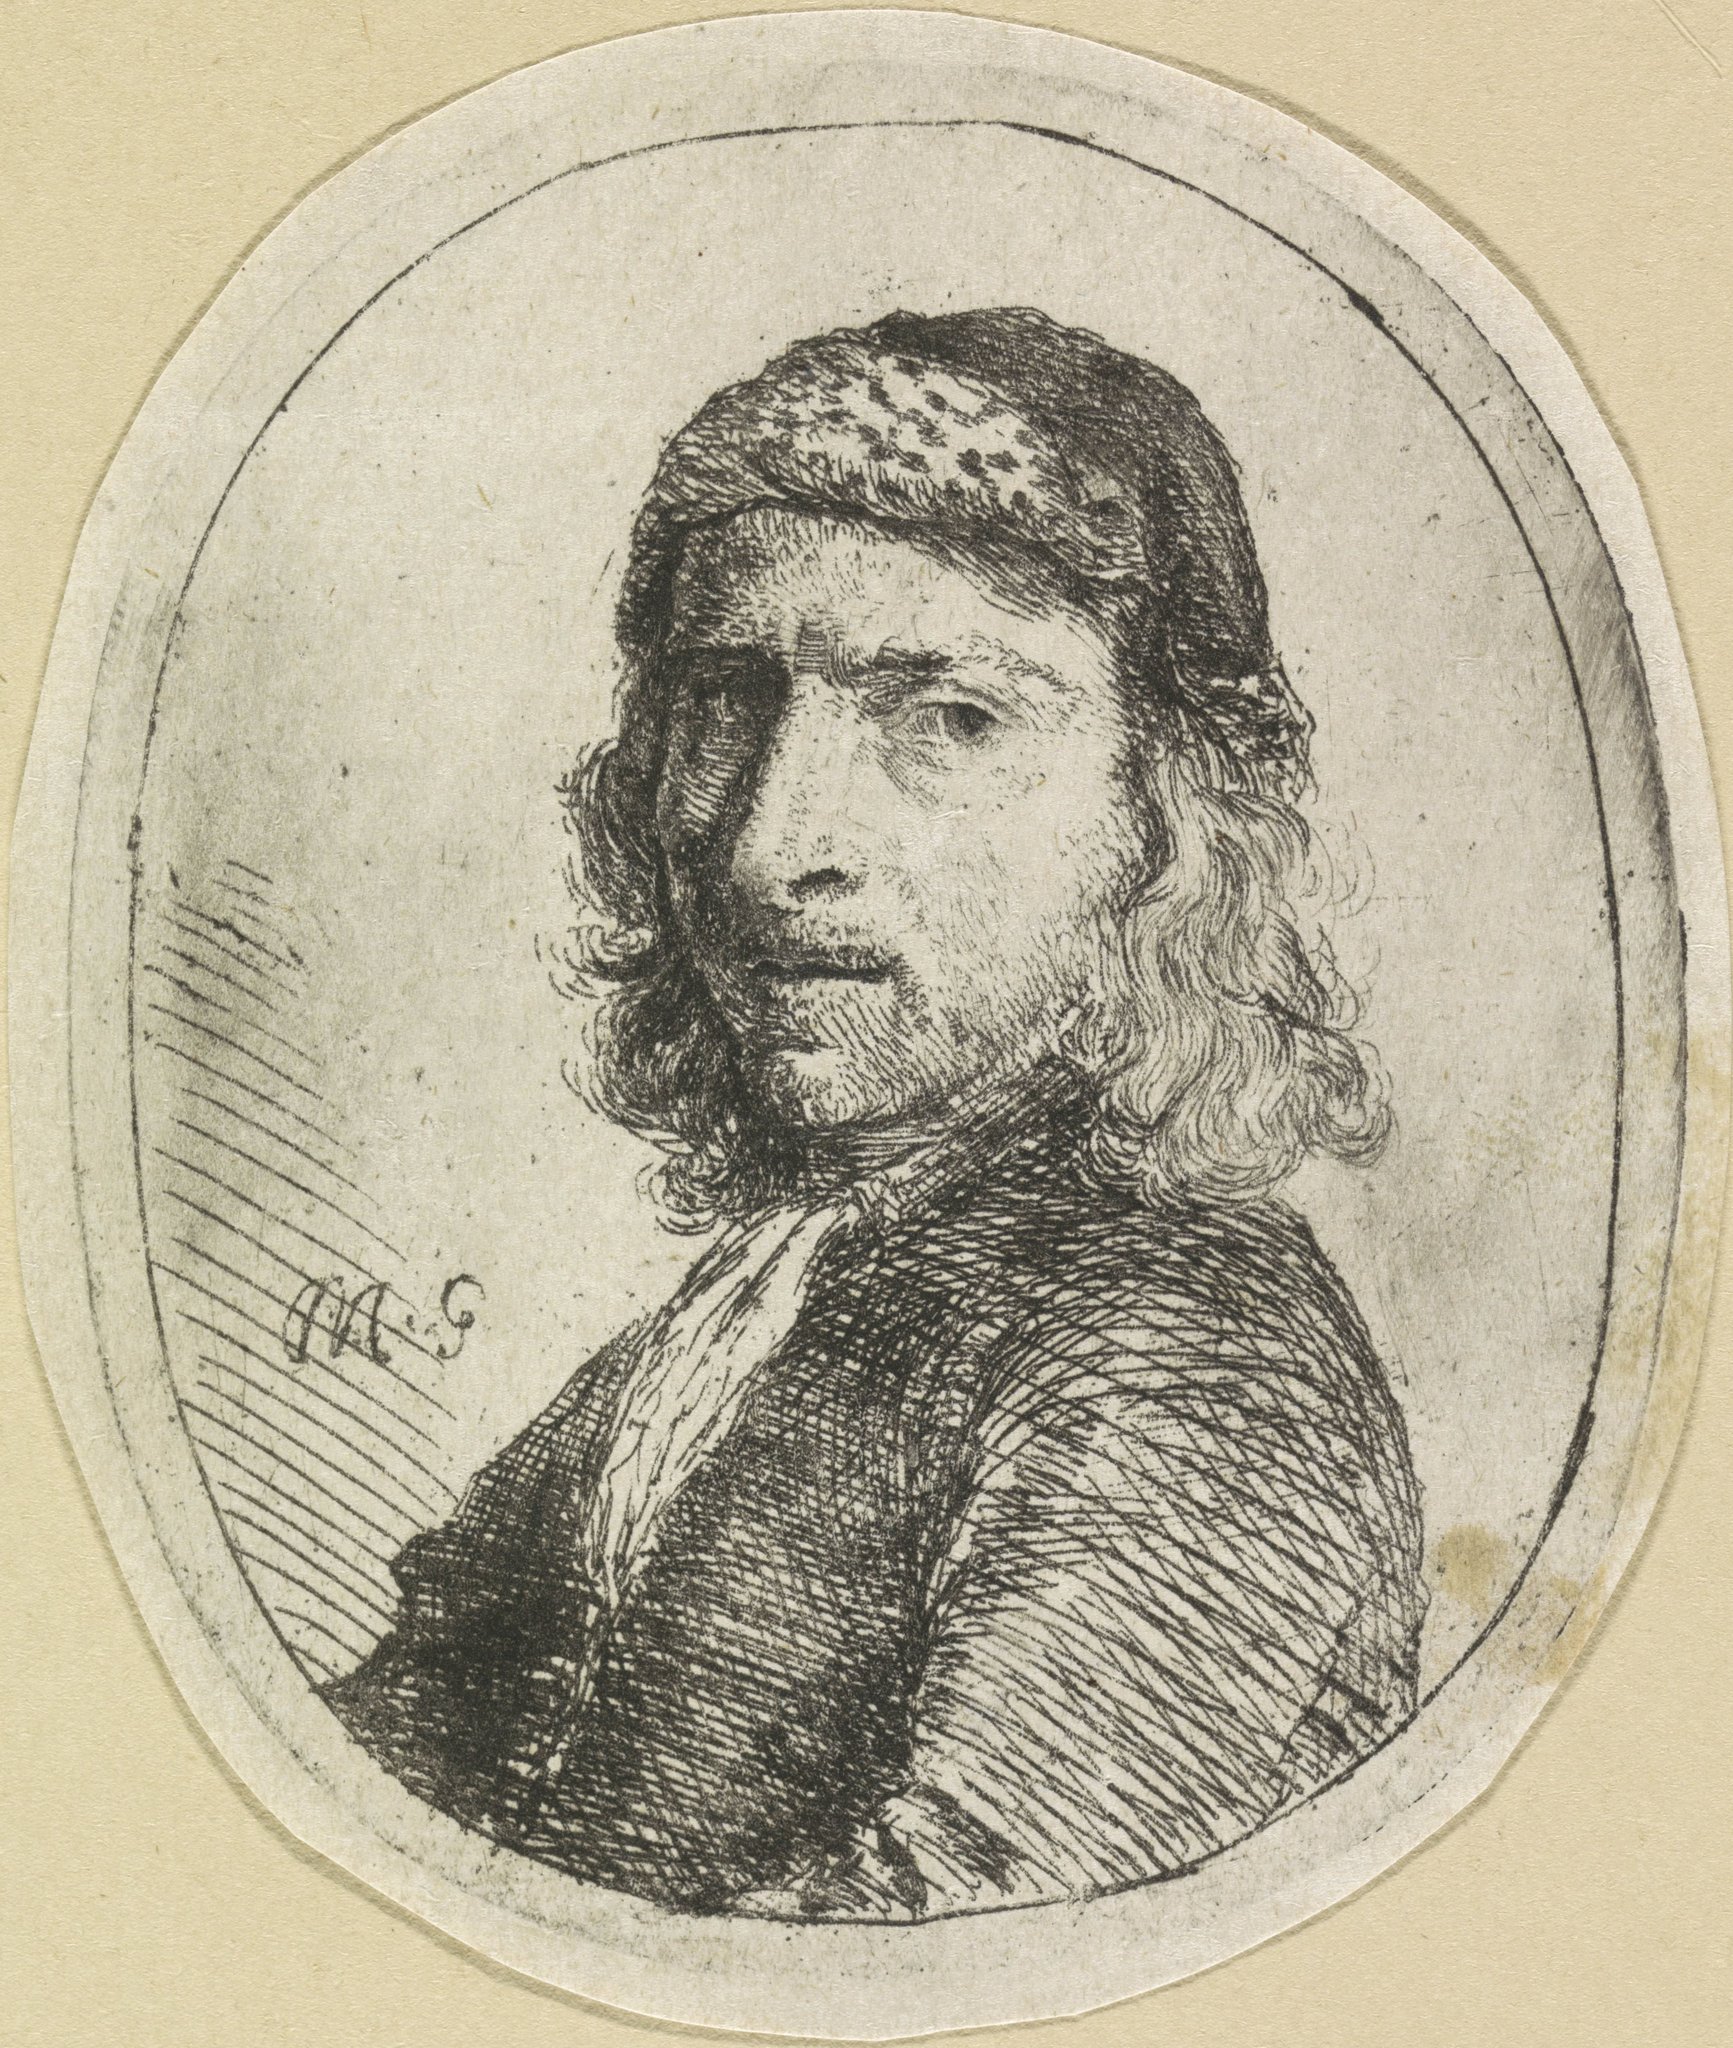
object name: print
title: Portret van een man mogelijk Marcus Gerards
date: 1630-1670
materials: paper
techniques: etching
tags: bruges, painter, print maker, draughtsman, marcus gheeraerts (i)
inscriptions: collector's mark: Lugt 2228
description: Portret van een man met een muts op het hoofd. Mogelijk de schilder Marcus Gerards.